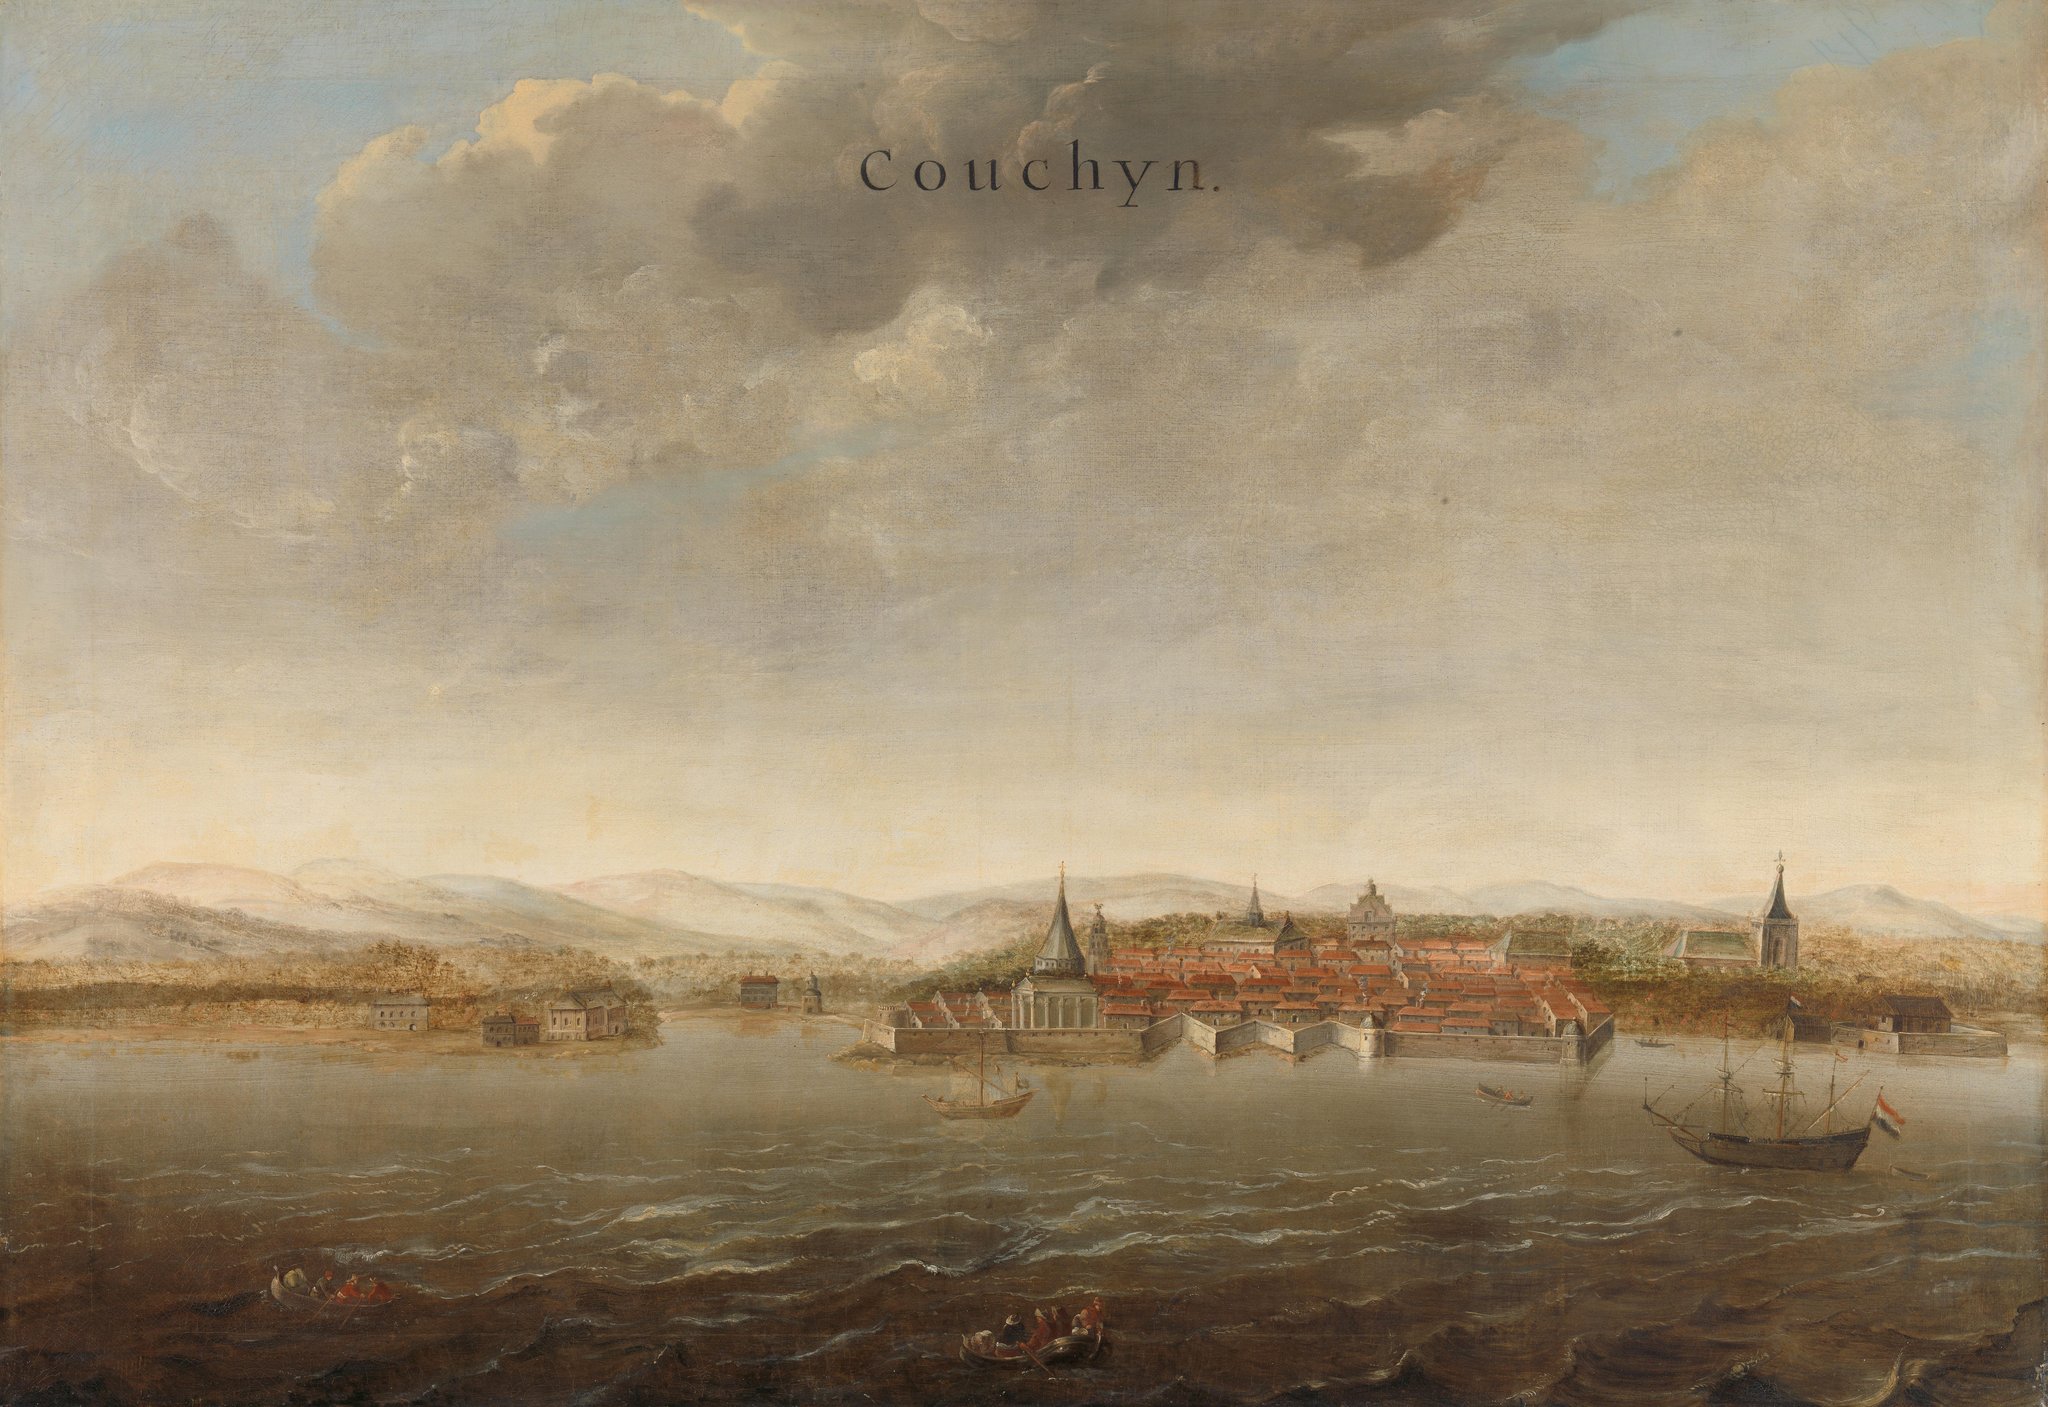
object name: painting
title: Trading posts of the Dutch East India Company (VOC)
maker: johannes vinckboons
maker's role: draughtsman, print maker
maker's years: 1616-1670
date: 1662-1663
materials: linen, oil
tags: locations for trading, coast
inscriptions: inscription: ‘Couchyn.’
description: This series of paintings hanging high in a row here feature various trading posts of the Dutch East India Company (VOC) in Asia. It was a network between which not only products but also enslaved people were transported. The VOC shipped between 660,000 and 1,135,000 people in the 17th and 18th centuries.